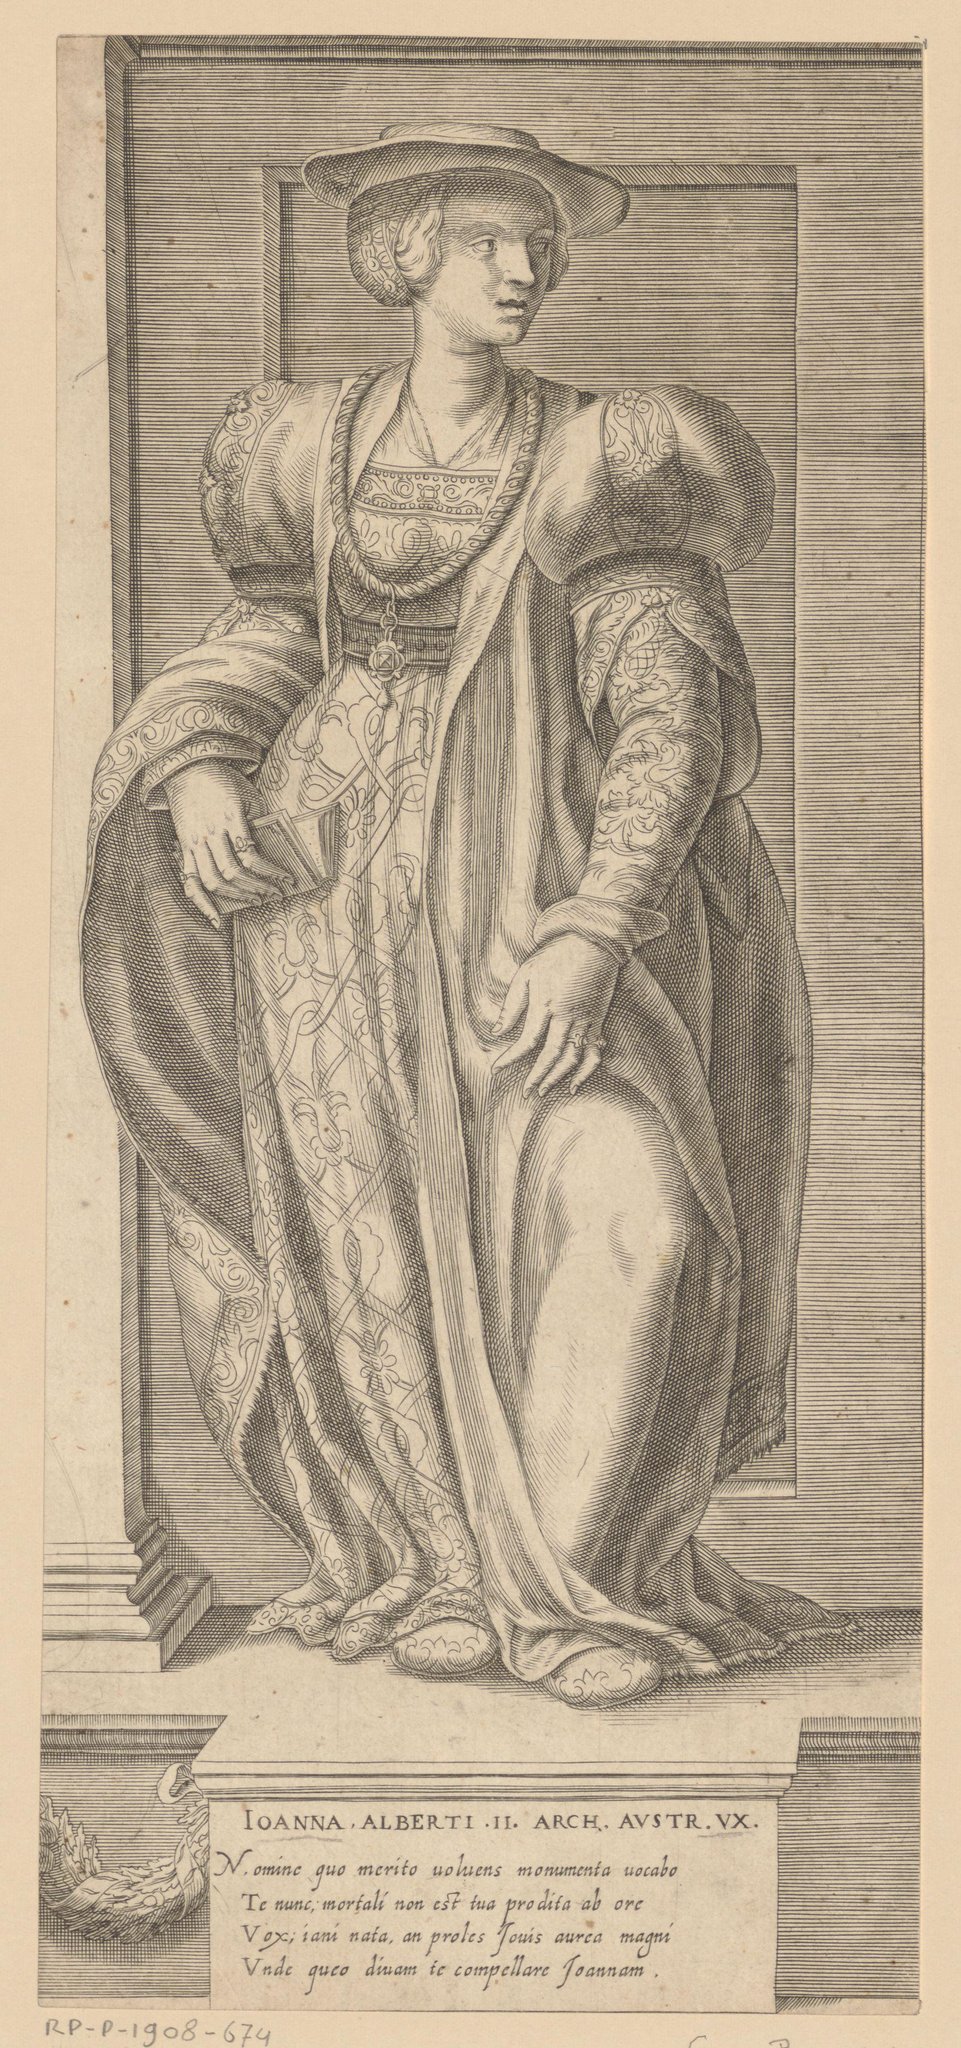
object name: print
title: Portret van Johanna van Pfirt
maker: gaspare oselli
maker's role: print maker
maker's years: 1536-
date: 1569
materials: paper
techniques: engraving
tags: vienna, historical persons - bb - woman, book, standing figure - aa - female human figure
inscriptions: collector's mark: Lugt 2228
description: Deze prent maakt deel uit van een grotere prent met twee portretten die later verknipt is. De prent is waarschijnlijk gebruikt in een uitgave van de prentserie 'Austriacae gentis imaginum', bestaande uit 58 prenten. Het merendeel van deze prenten bevat portretten van 74 leden van het Oostenrijkse Huis, naar tekeningen door Francesco Terzio, die deels getekend zijn naar de 28 levensgrote bronzen beelden die rond de cenotaaf van Maximiliaan I in de Hofkirche te Innsbruck staan.